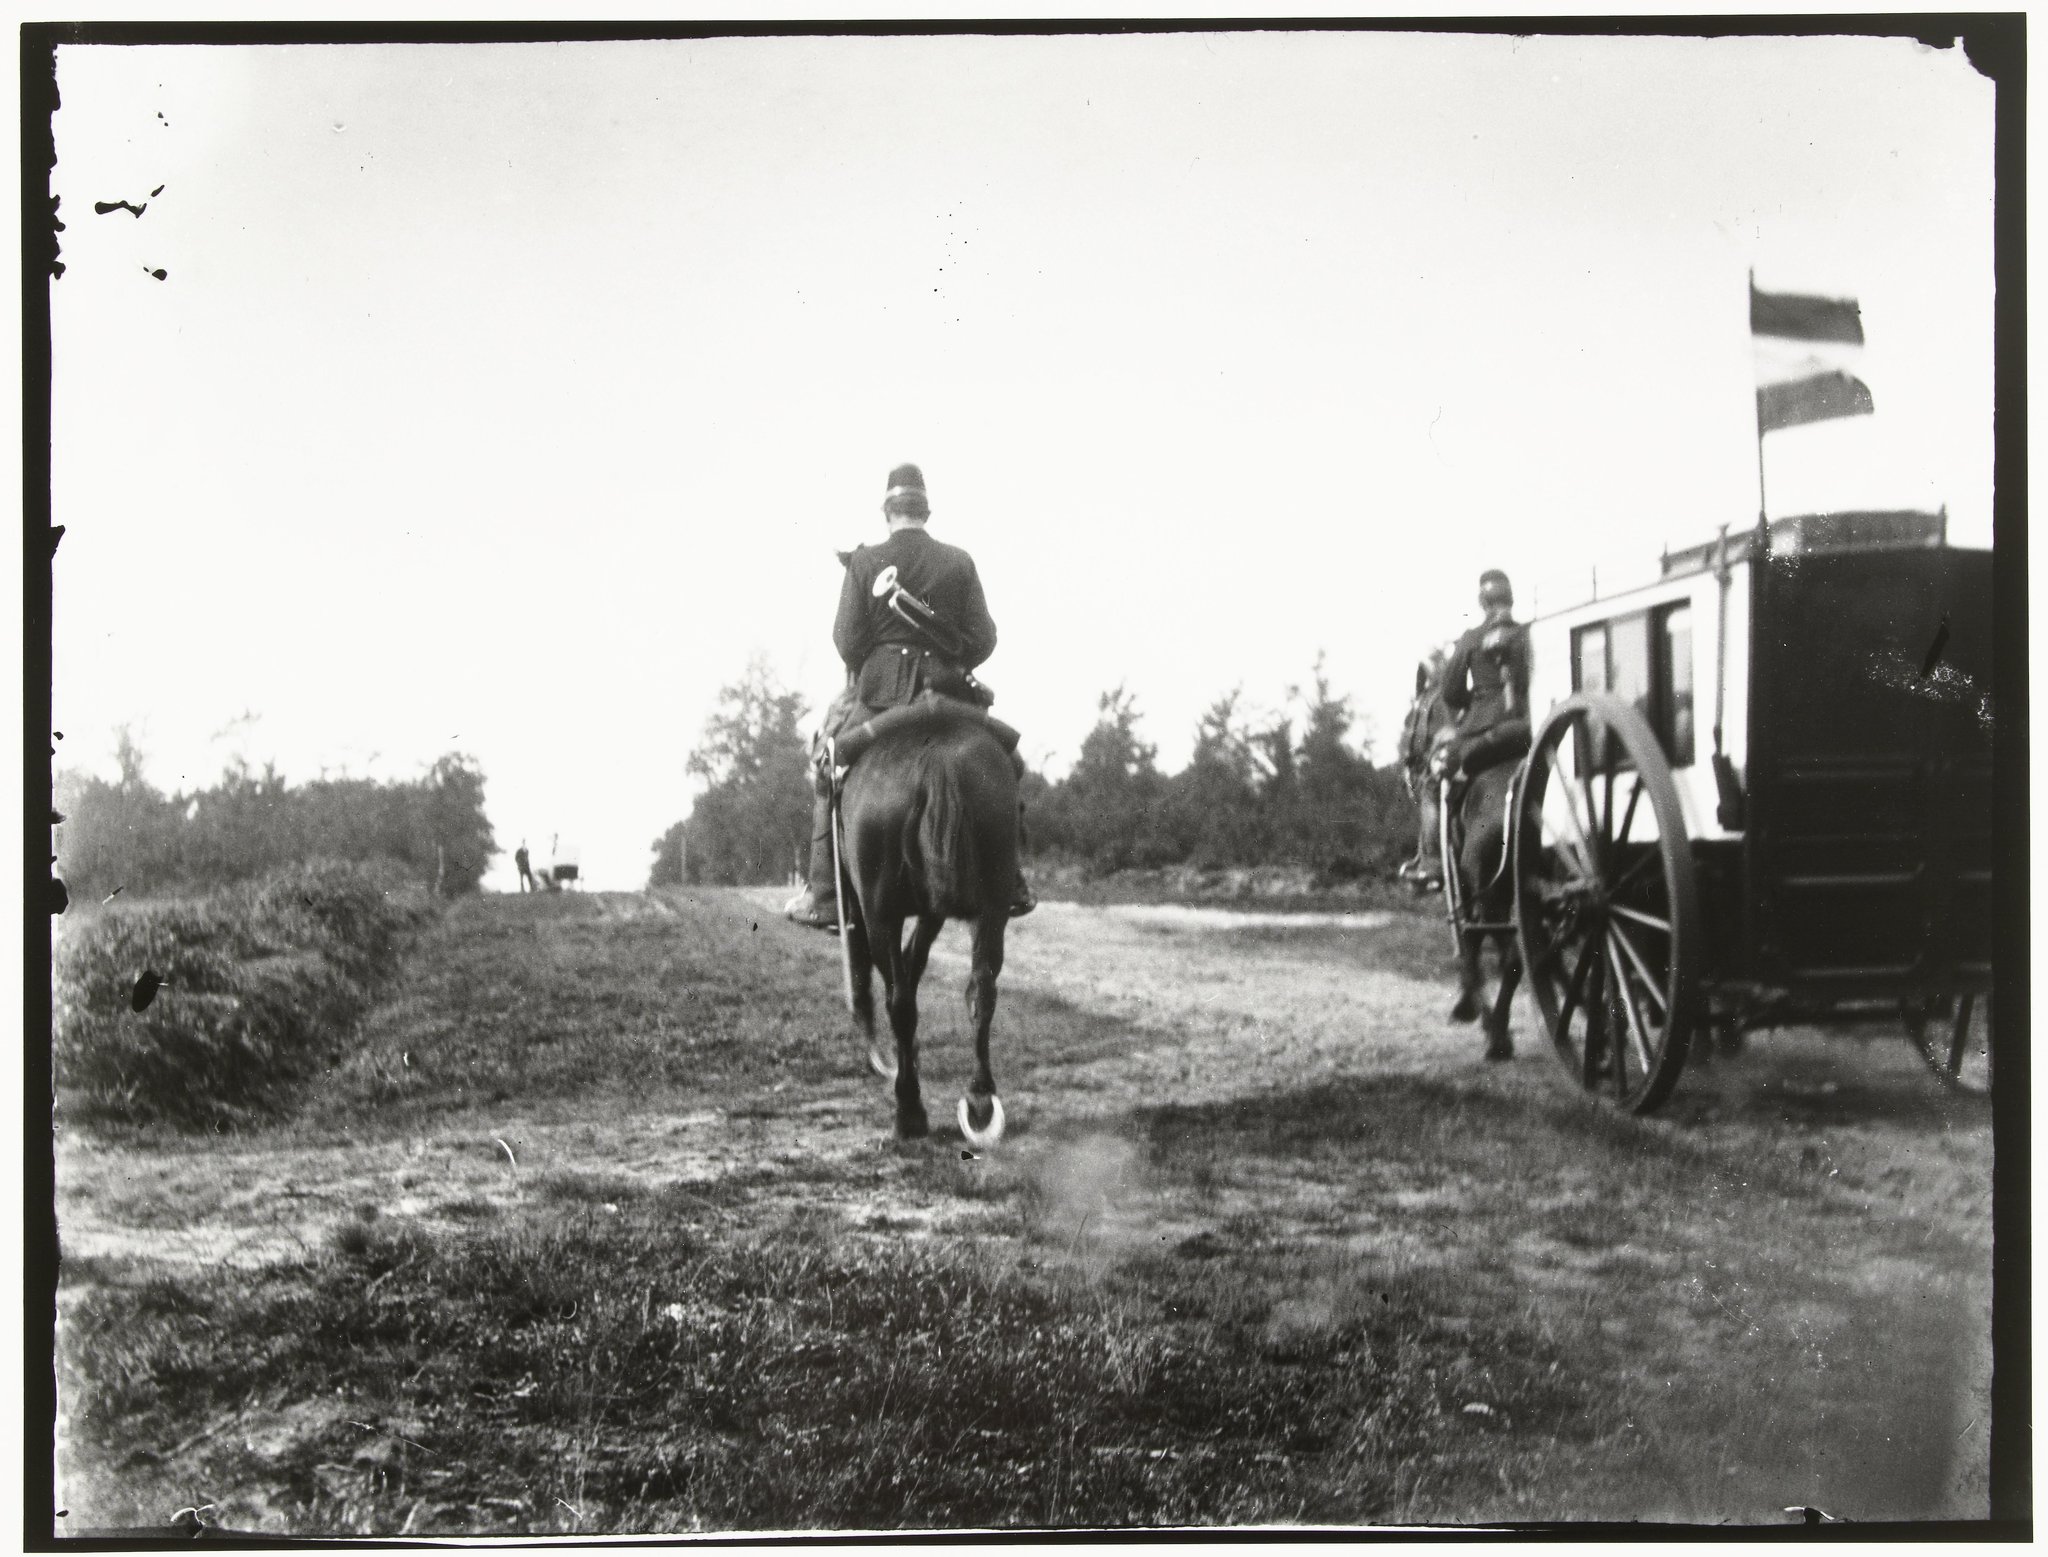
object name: photograph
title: Gele Rijders te paard in de buurt van Arnhem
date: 1890-1910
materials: paper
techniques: gelatin silver print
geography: netherlands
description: Moderne afdruk van negatief BR 1579 (collectie RKD).